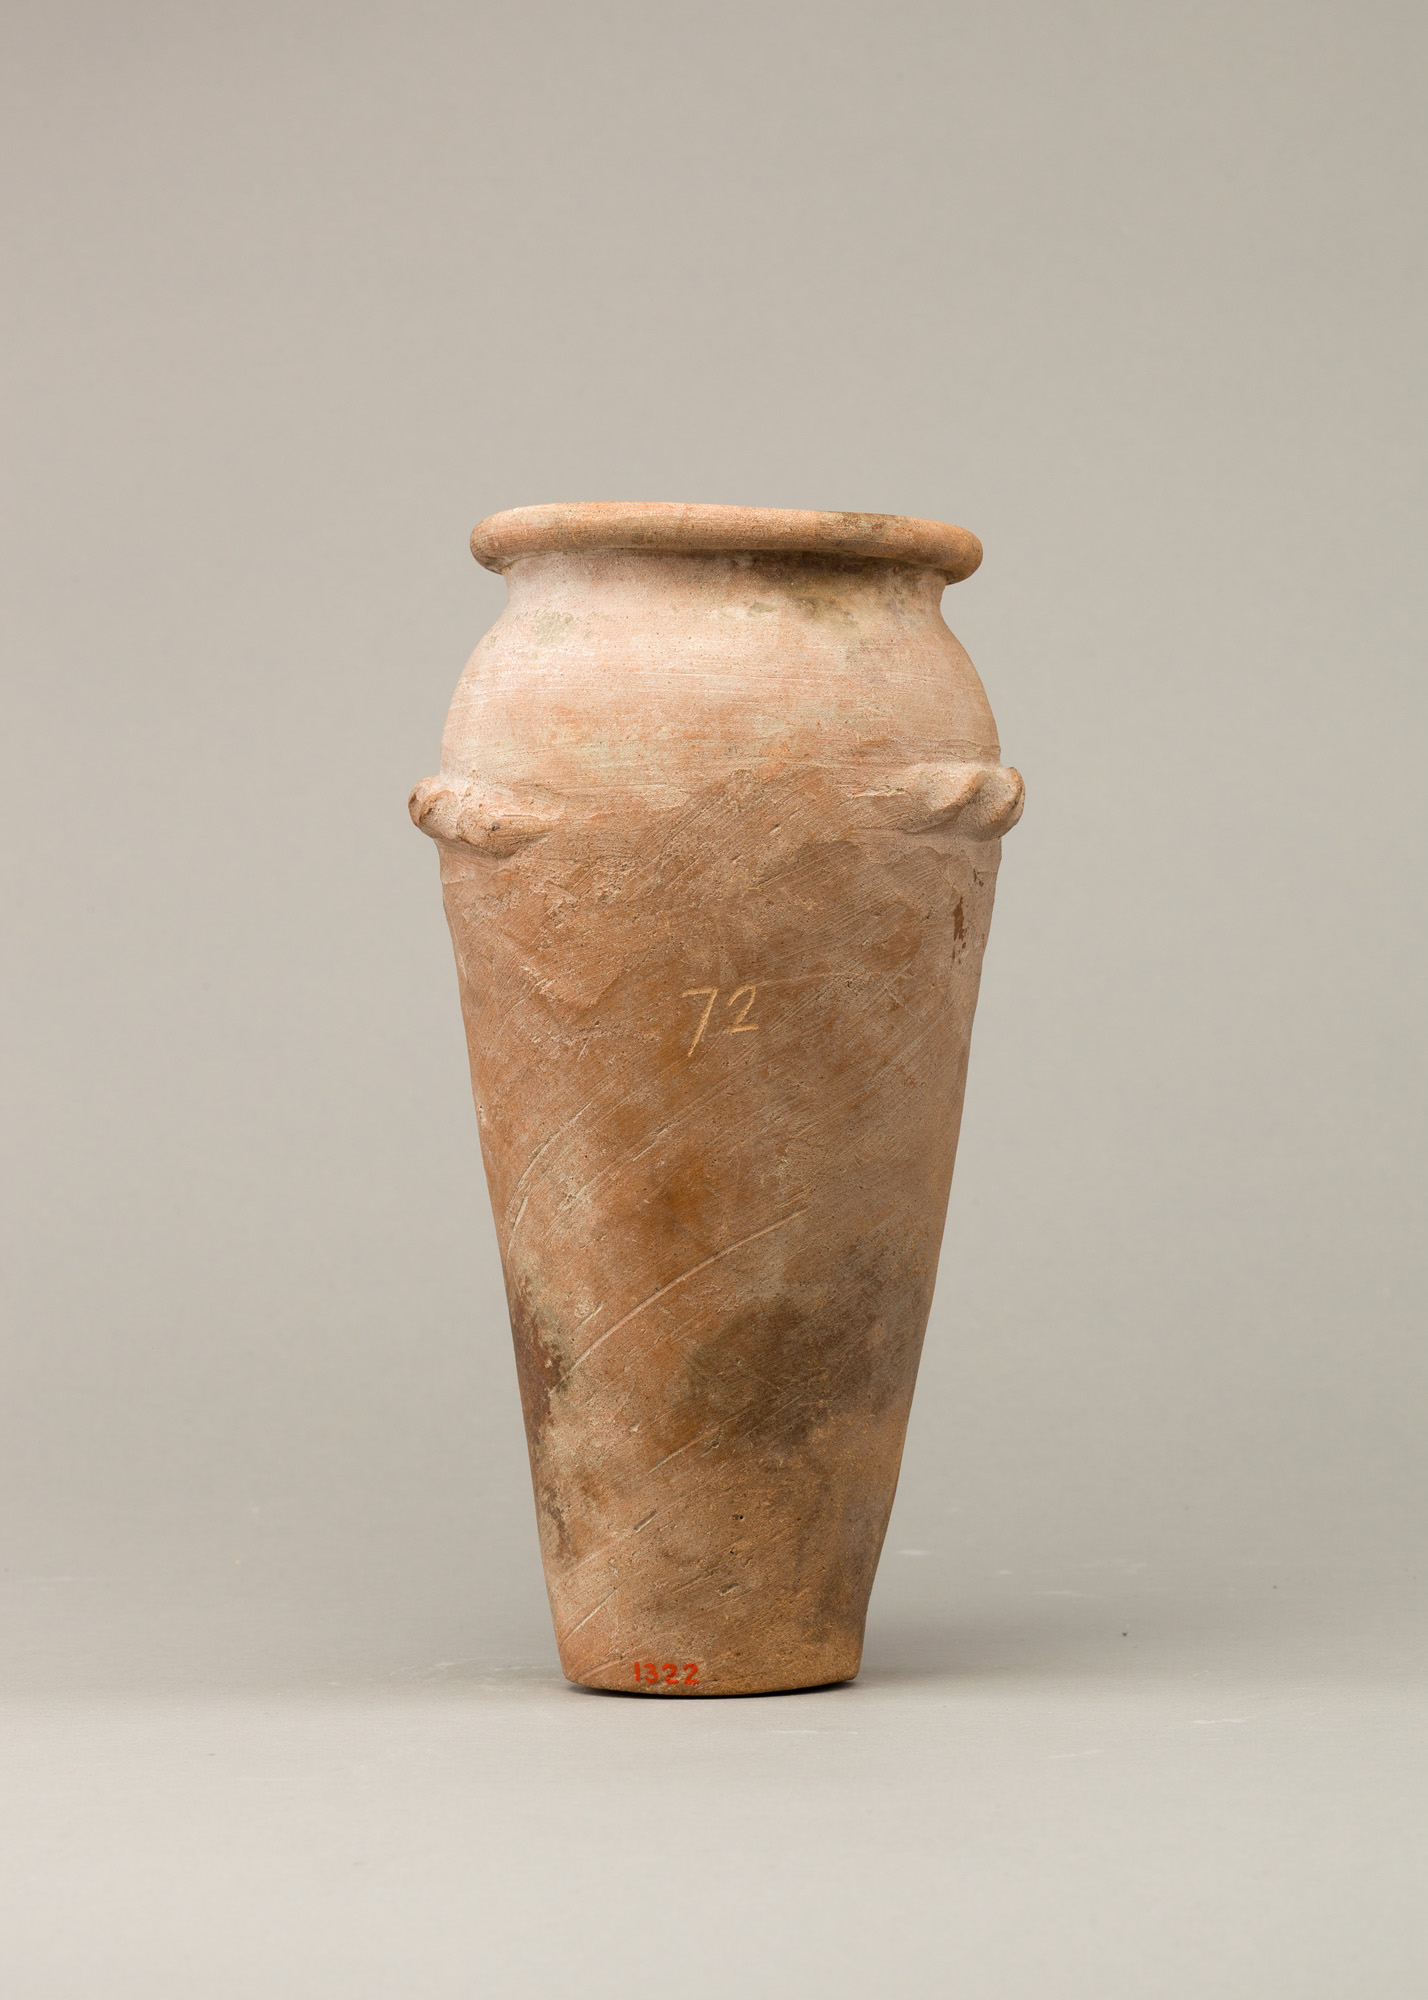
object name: jar, wavy handled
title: Wavy-handled jar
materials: pottery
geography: northern upper egypt